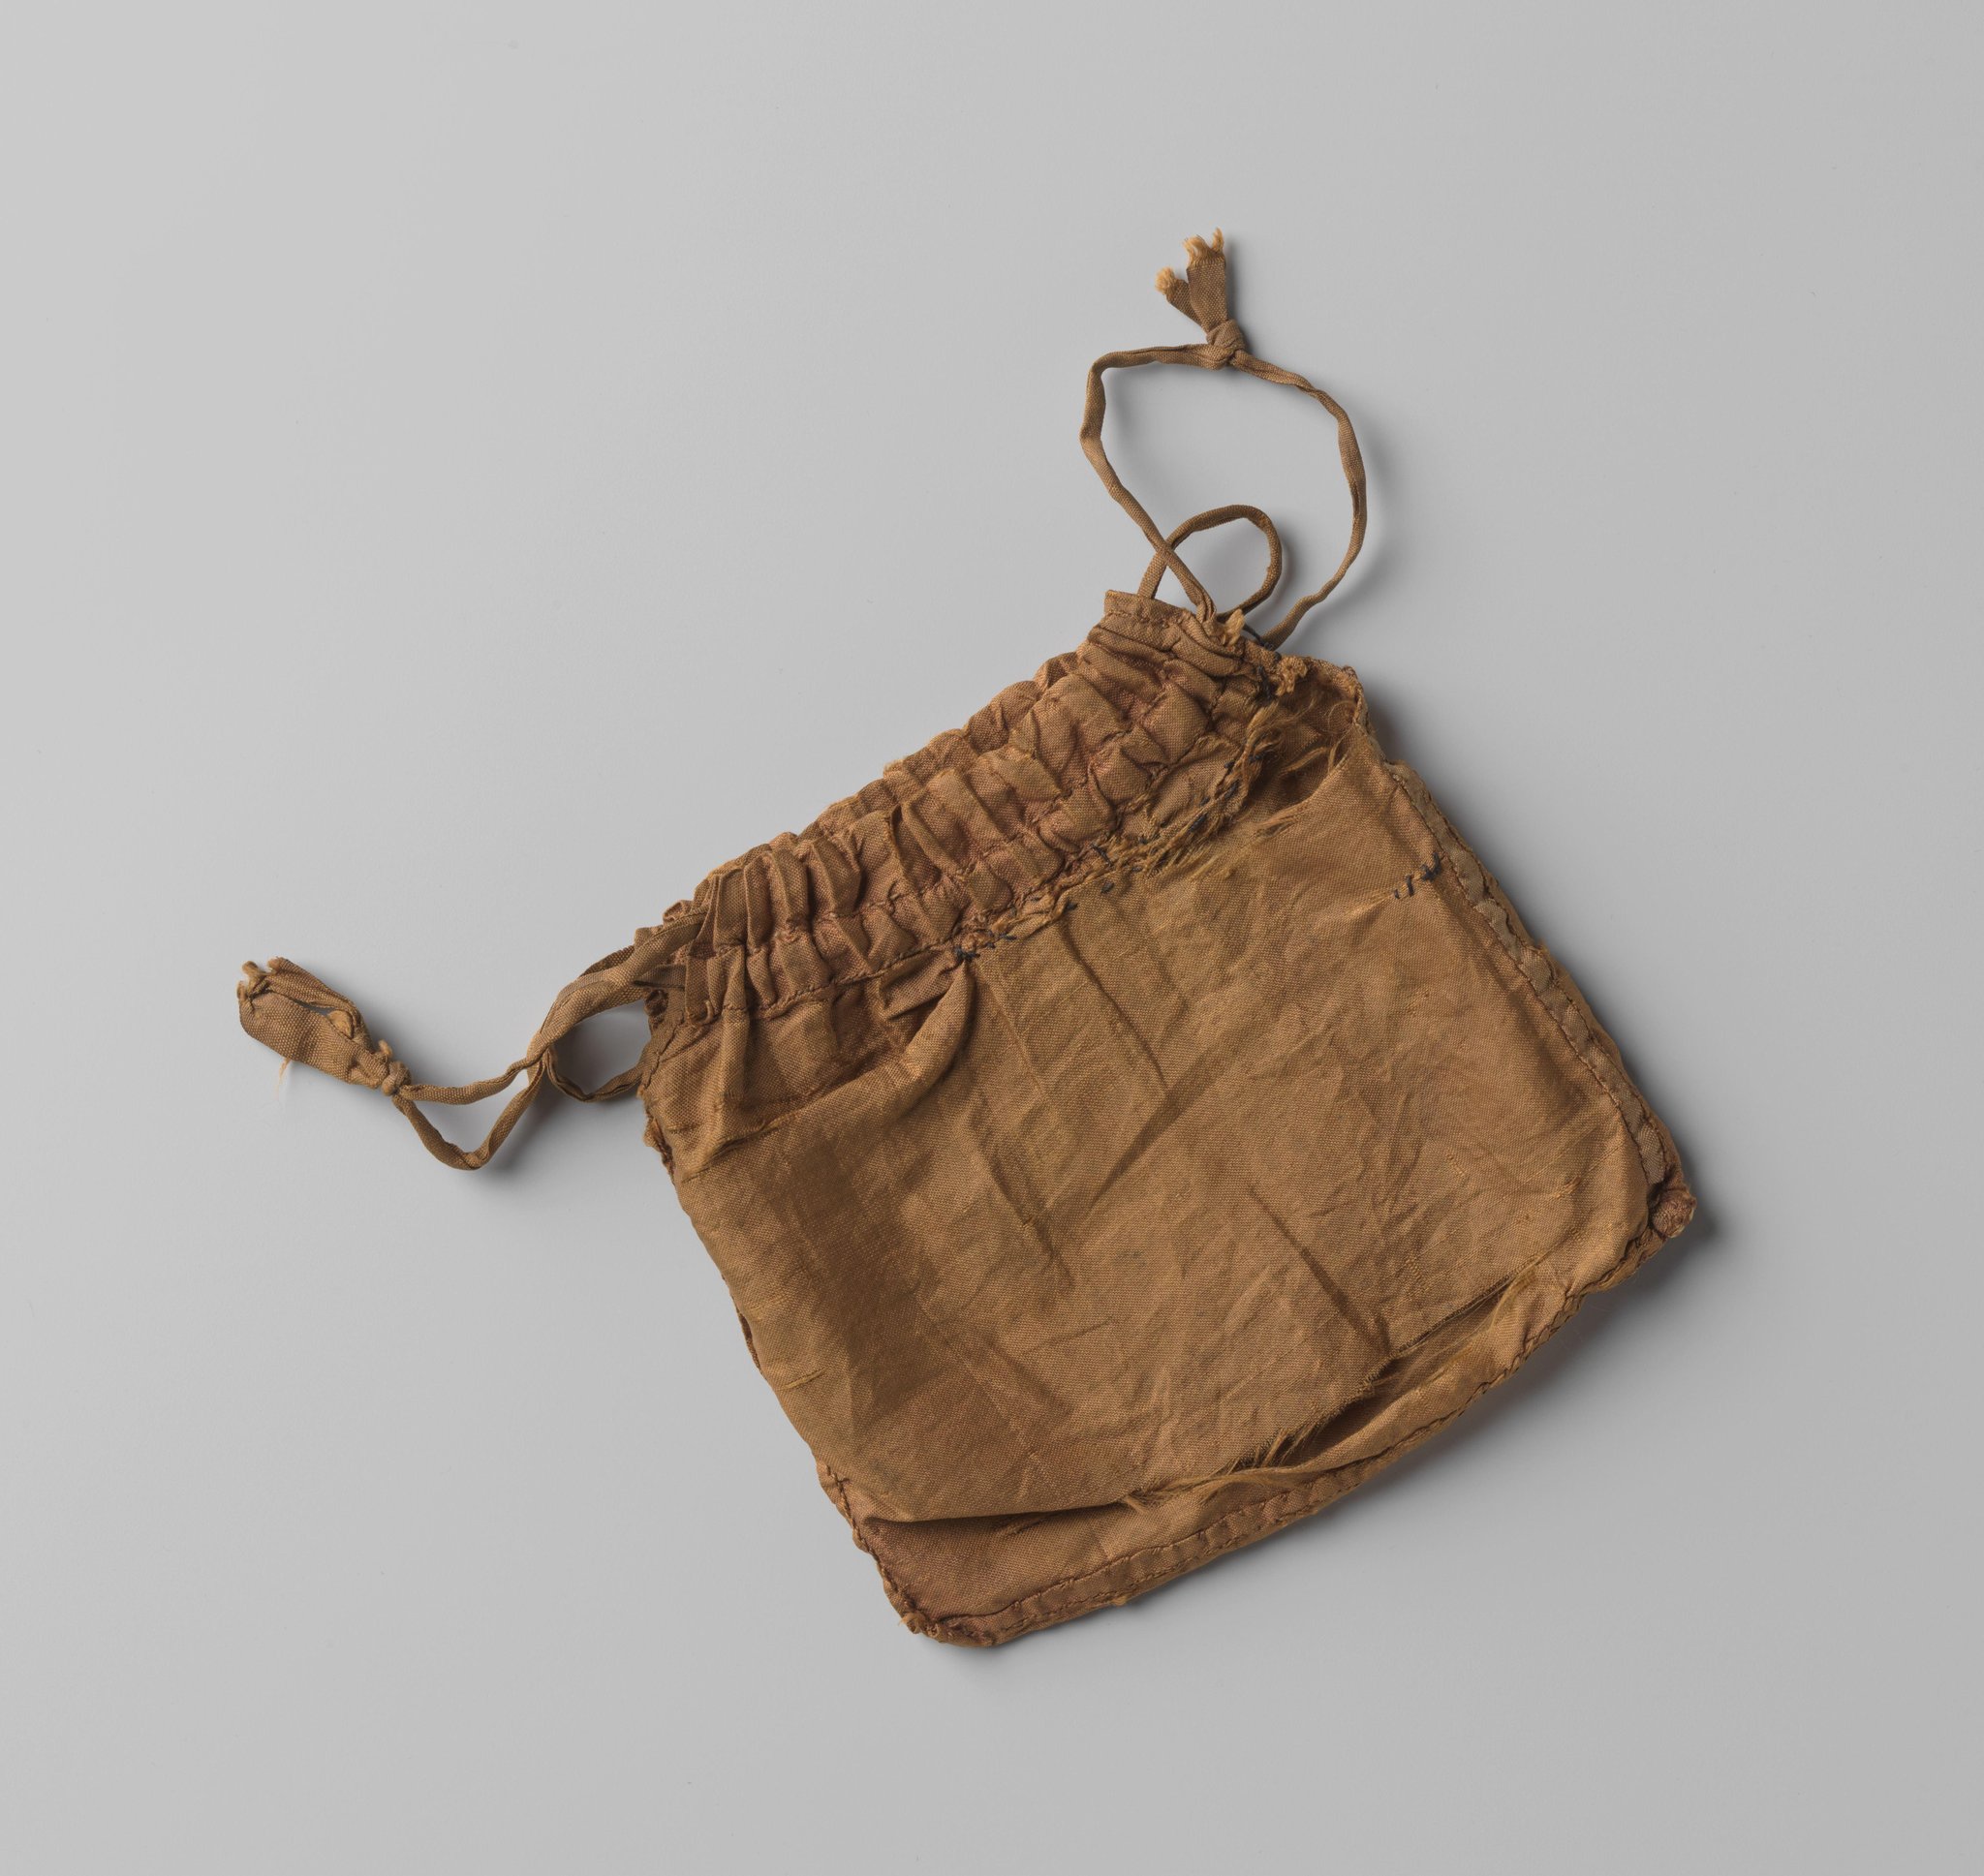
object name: sack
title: Zakje van verklikker met portret van Hendrik Danielszoon Hooft, burgemeester van Amsterdam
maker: Anonymous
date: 1780-1787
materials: silk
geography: netherlands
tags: amsterdam, hendrik danielsz. hooft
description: Zakje van verklikker met portret van Hendrik Danielszoon Hooft, burgemeester van Amsterdam. Bruin zijden zakje met langs bovenzijde dubbele tunnel met zijden lint. Het zakje is in slechte conditie en heeft o.a. glissen bij de bodem en aan een zijde onder de tunnel. Er zijn vele herstellingen met grof zwart garen.